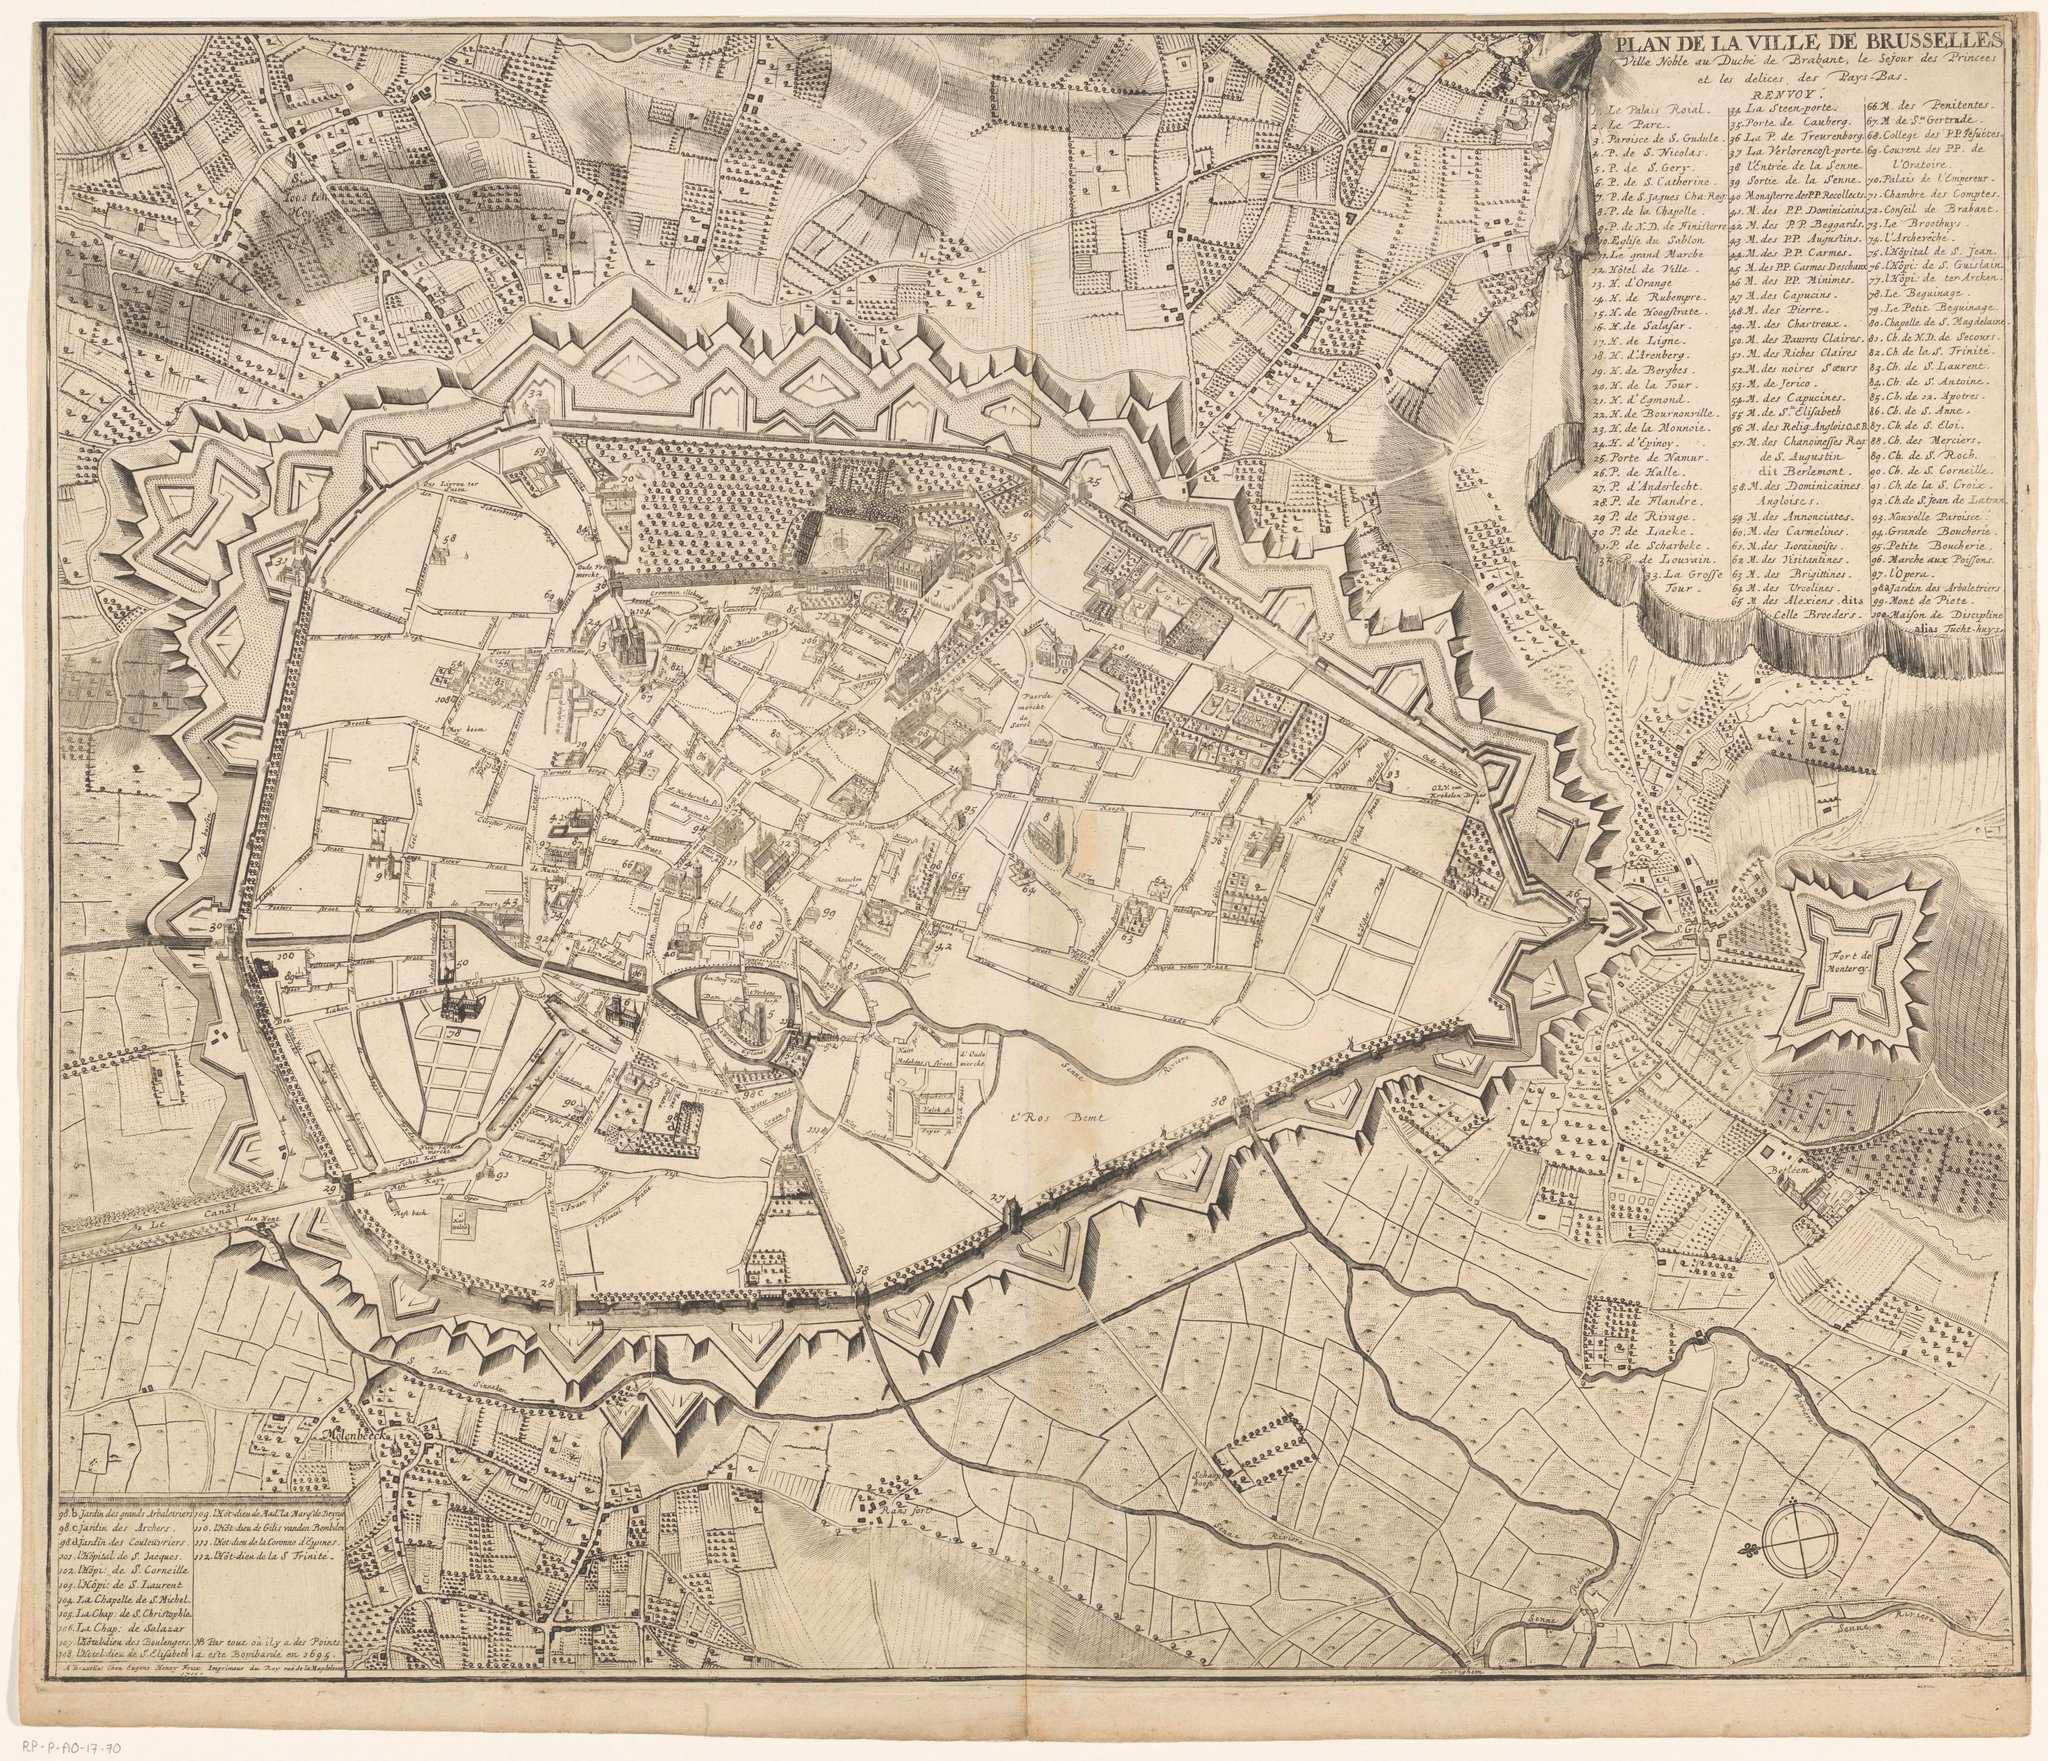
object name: area plan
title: Plattegrond van Brussel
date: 1711-1712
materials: paper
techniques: engraving, etching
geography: brussels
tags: fortified city, maps of cities, brussels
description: Prent ook gebruikt in: Table des cartes des Pays Bas et des frontières de France, avec un recueil des plans des villes, sièges et battailles données entre les hauts alliés et la France. Brussel: Eugene Henry Fricx, 1712. Bovenstaande publicatie kent meerdere drukken waarbij datum onveranderd is gebleven.